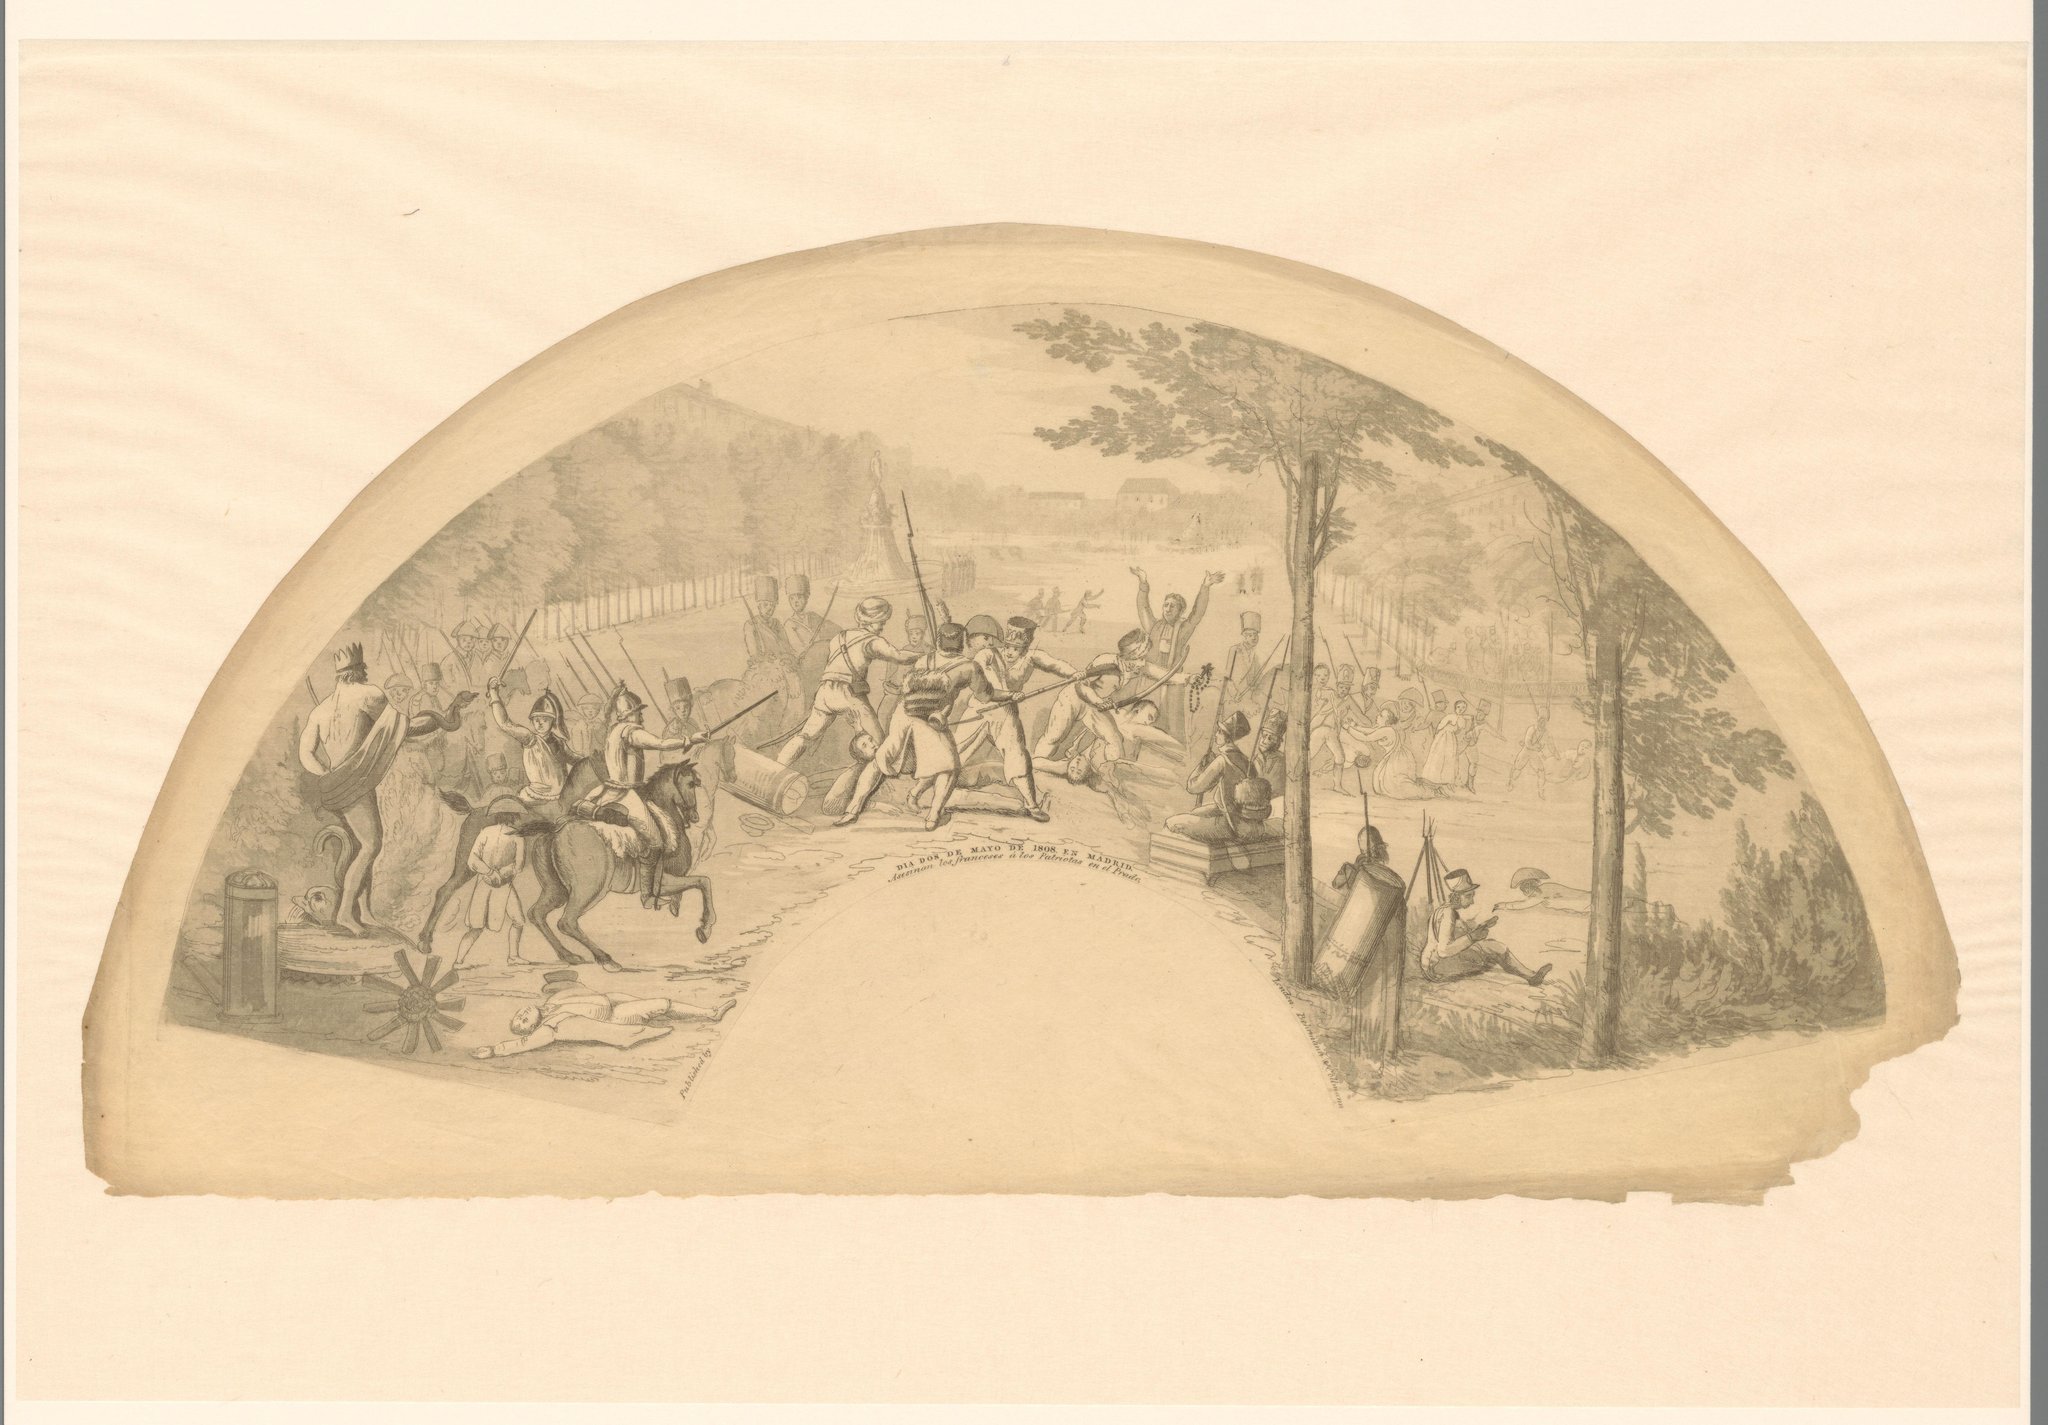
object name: waaierblad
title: Dia Dos de Mayo de 1808. En Madrid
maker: Anonymous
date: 1808-1825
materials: paper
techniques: aquatint, etching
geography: england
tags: massacre ~ war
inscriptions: collector's mark: Lugt 2760, collector's mark: Lugt 2228